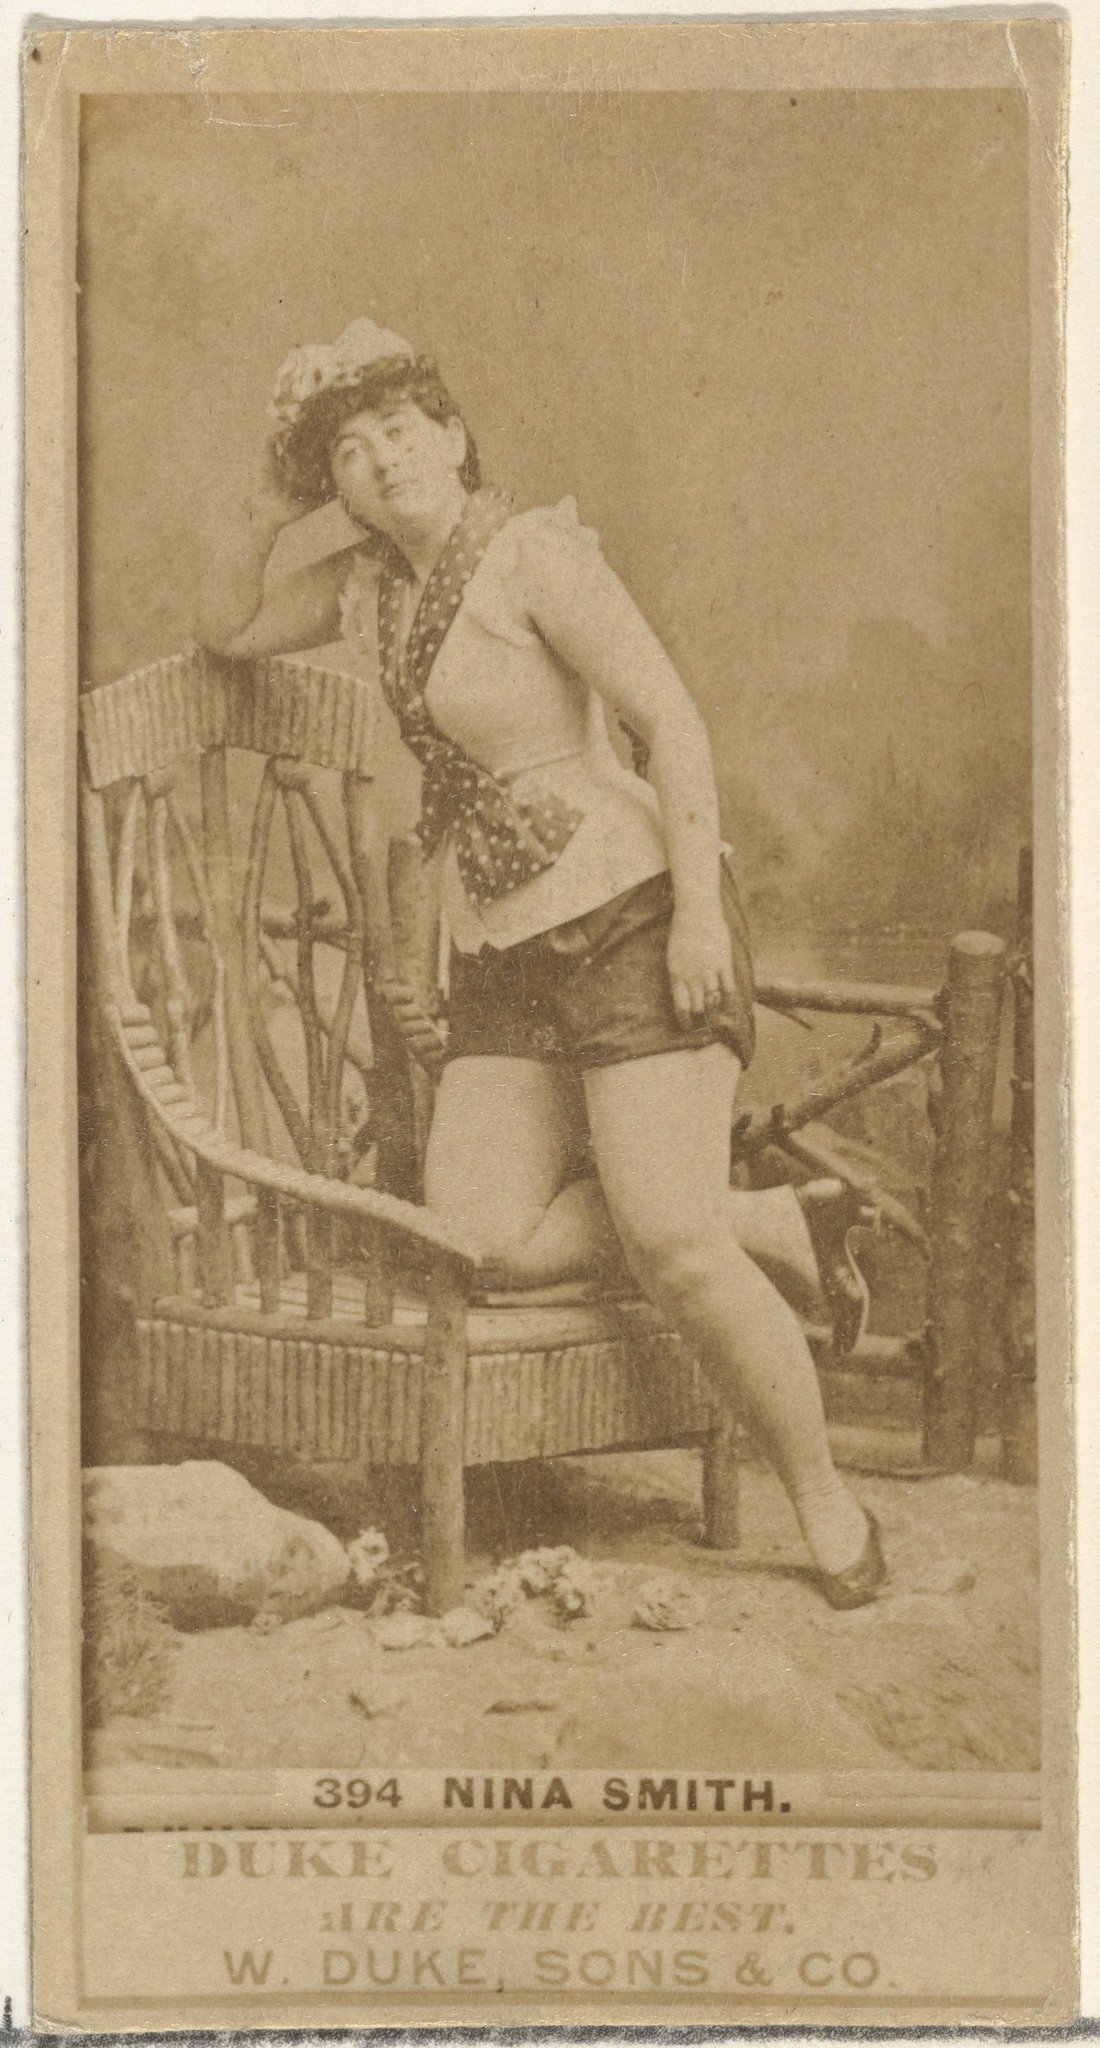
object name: photograph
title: Card Number 394, Nina Smith, from the Actors and Actresses series (N145-7) issued by Duke Sons & Co. to promote Duke Cigarettes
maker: w. duke, sons & co.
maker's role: publisher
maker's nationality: american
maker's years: 1870-1920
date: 1880-1889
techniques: albumen silver print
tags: portraits,women,actresses